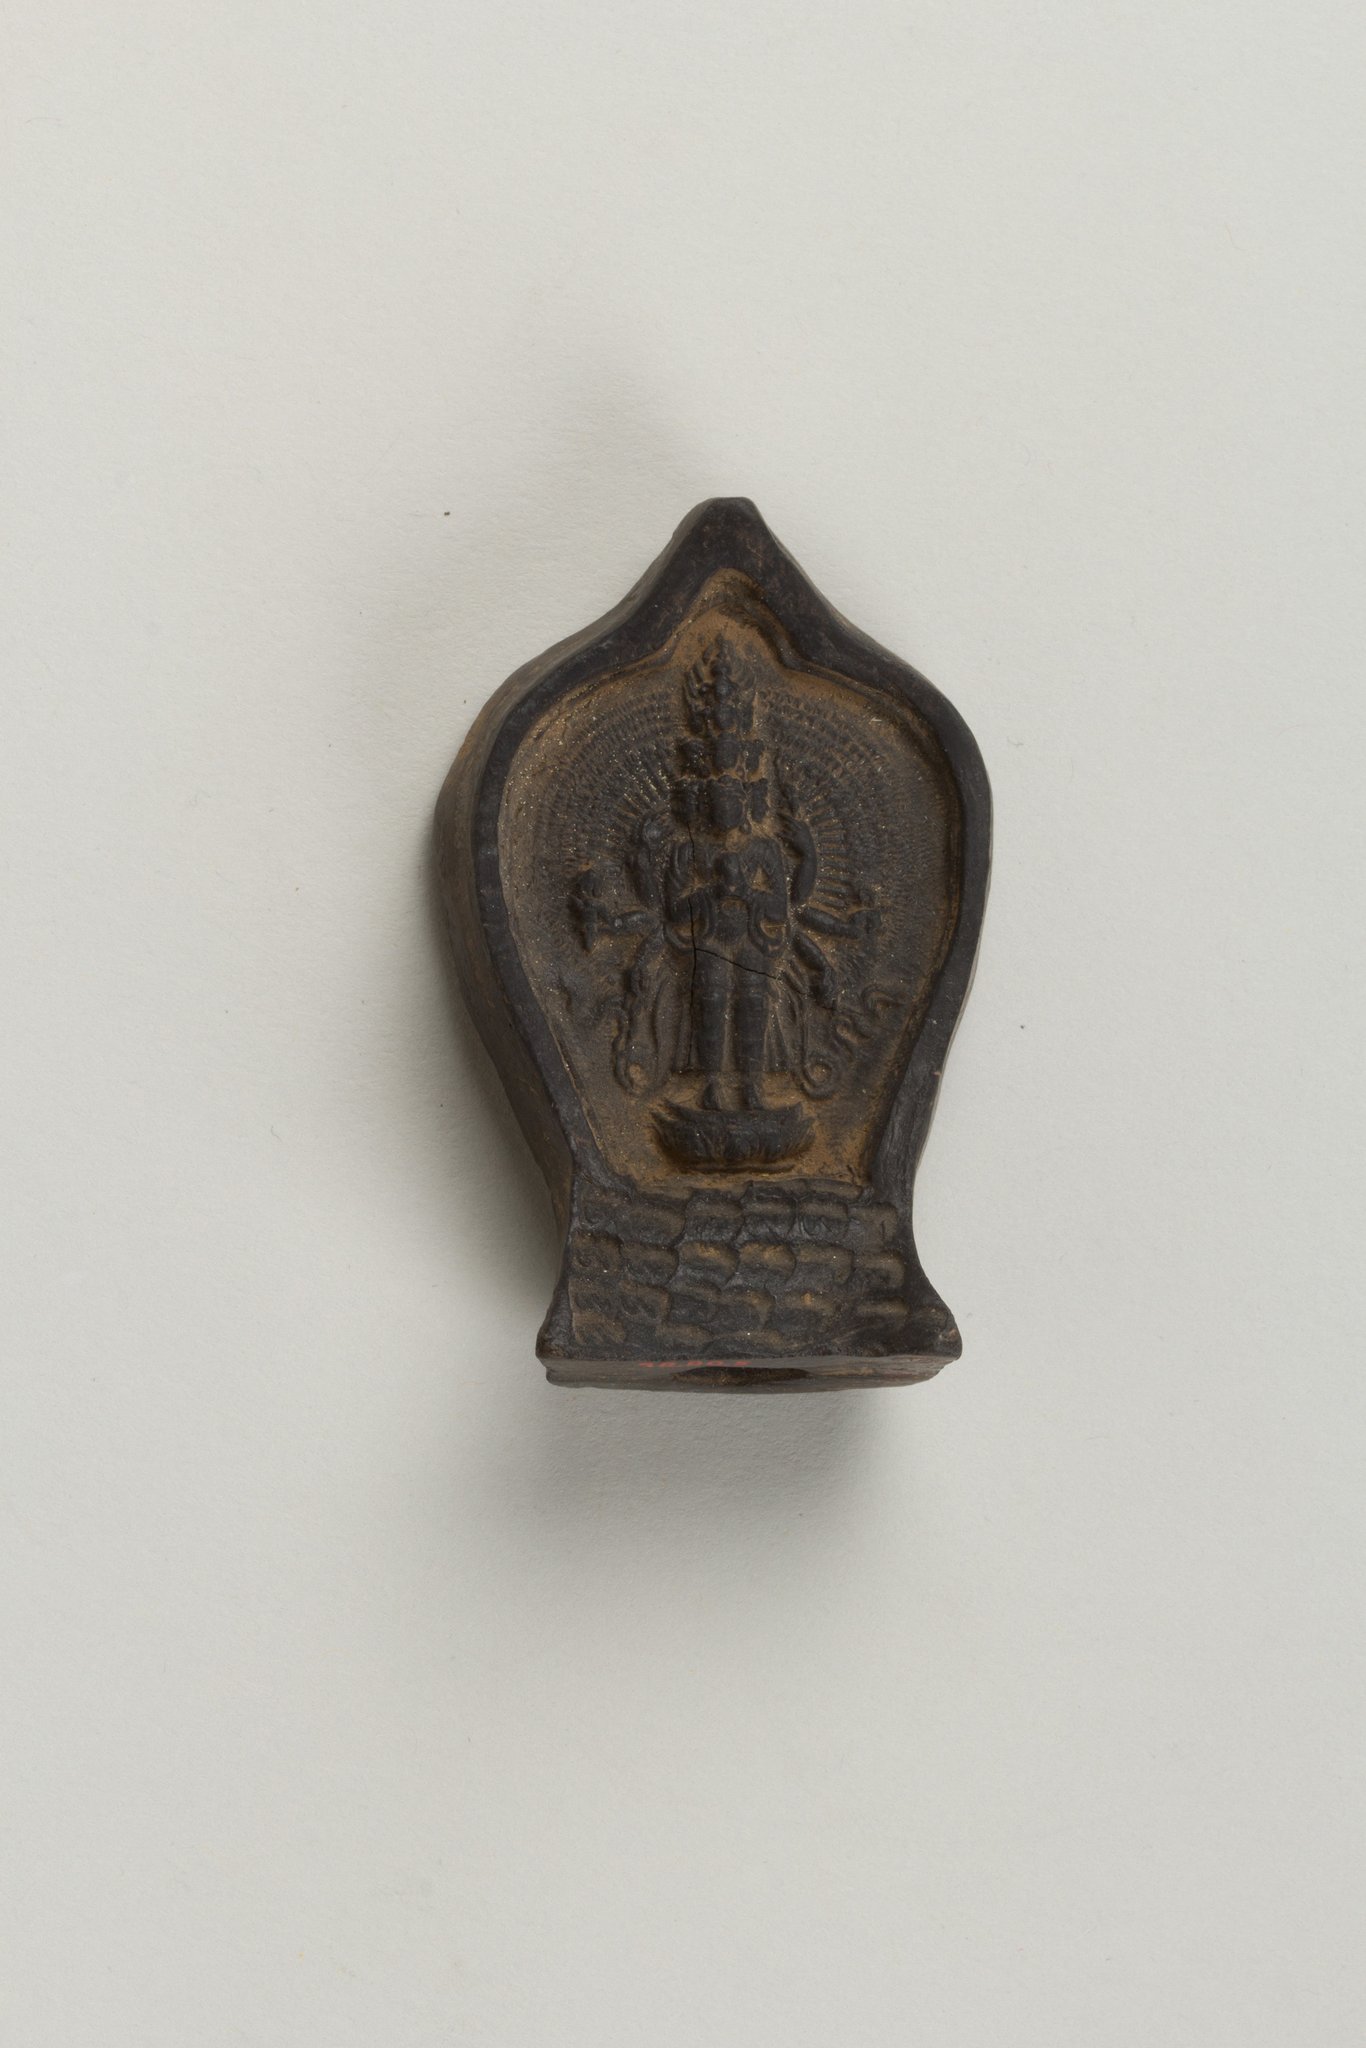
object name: votive plaque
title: Votive Plaque with a Thousand-Armed Avalokiteshvara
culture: tibetan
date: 1501-1800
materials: clay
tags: buddhism,avalokiteshvara,bodhisattvas